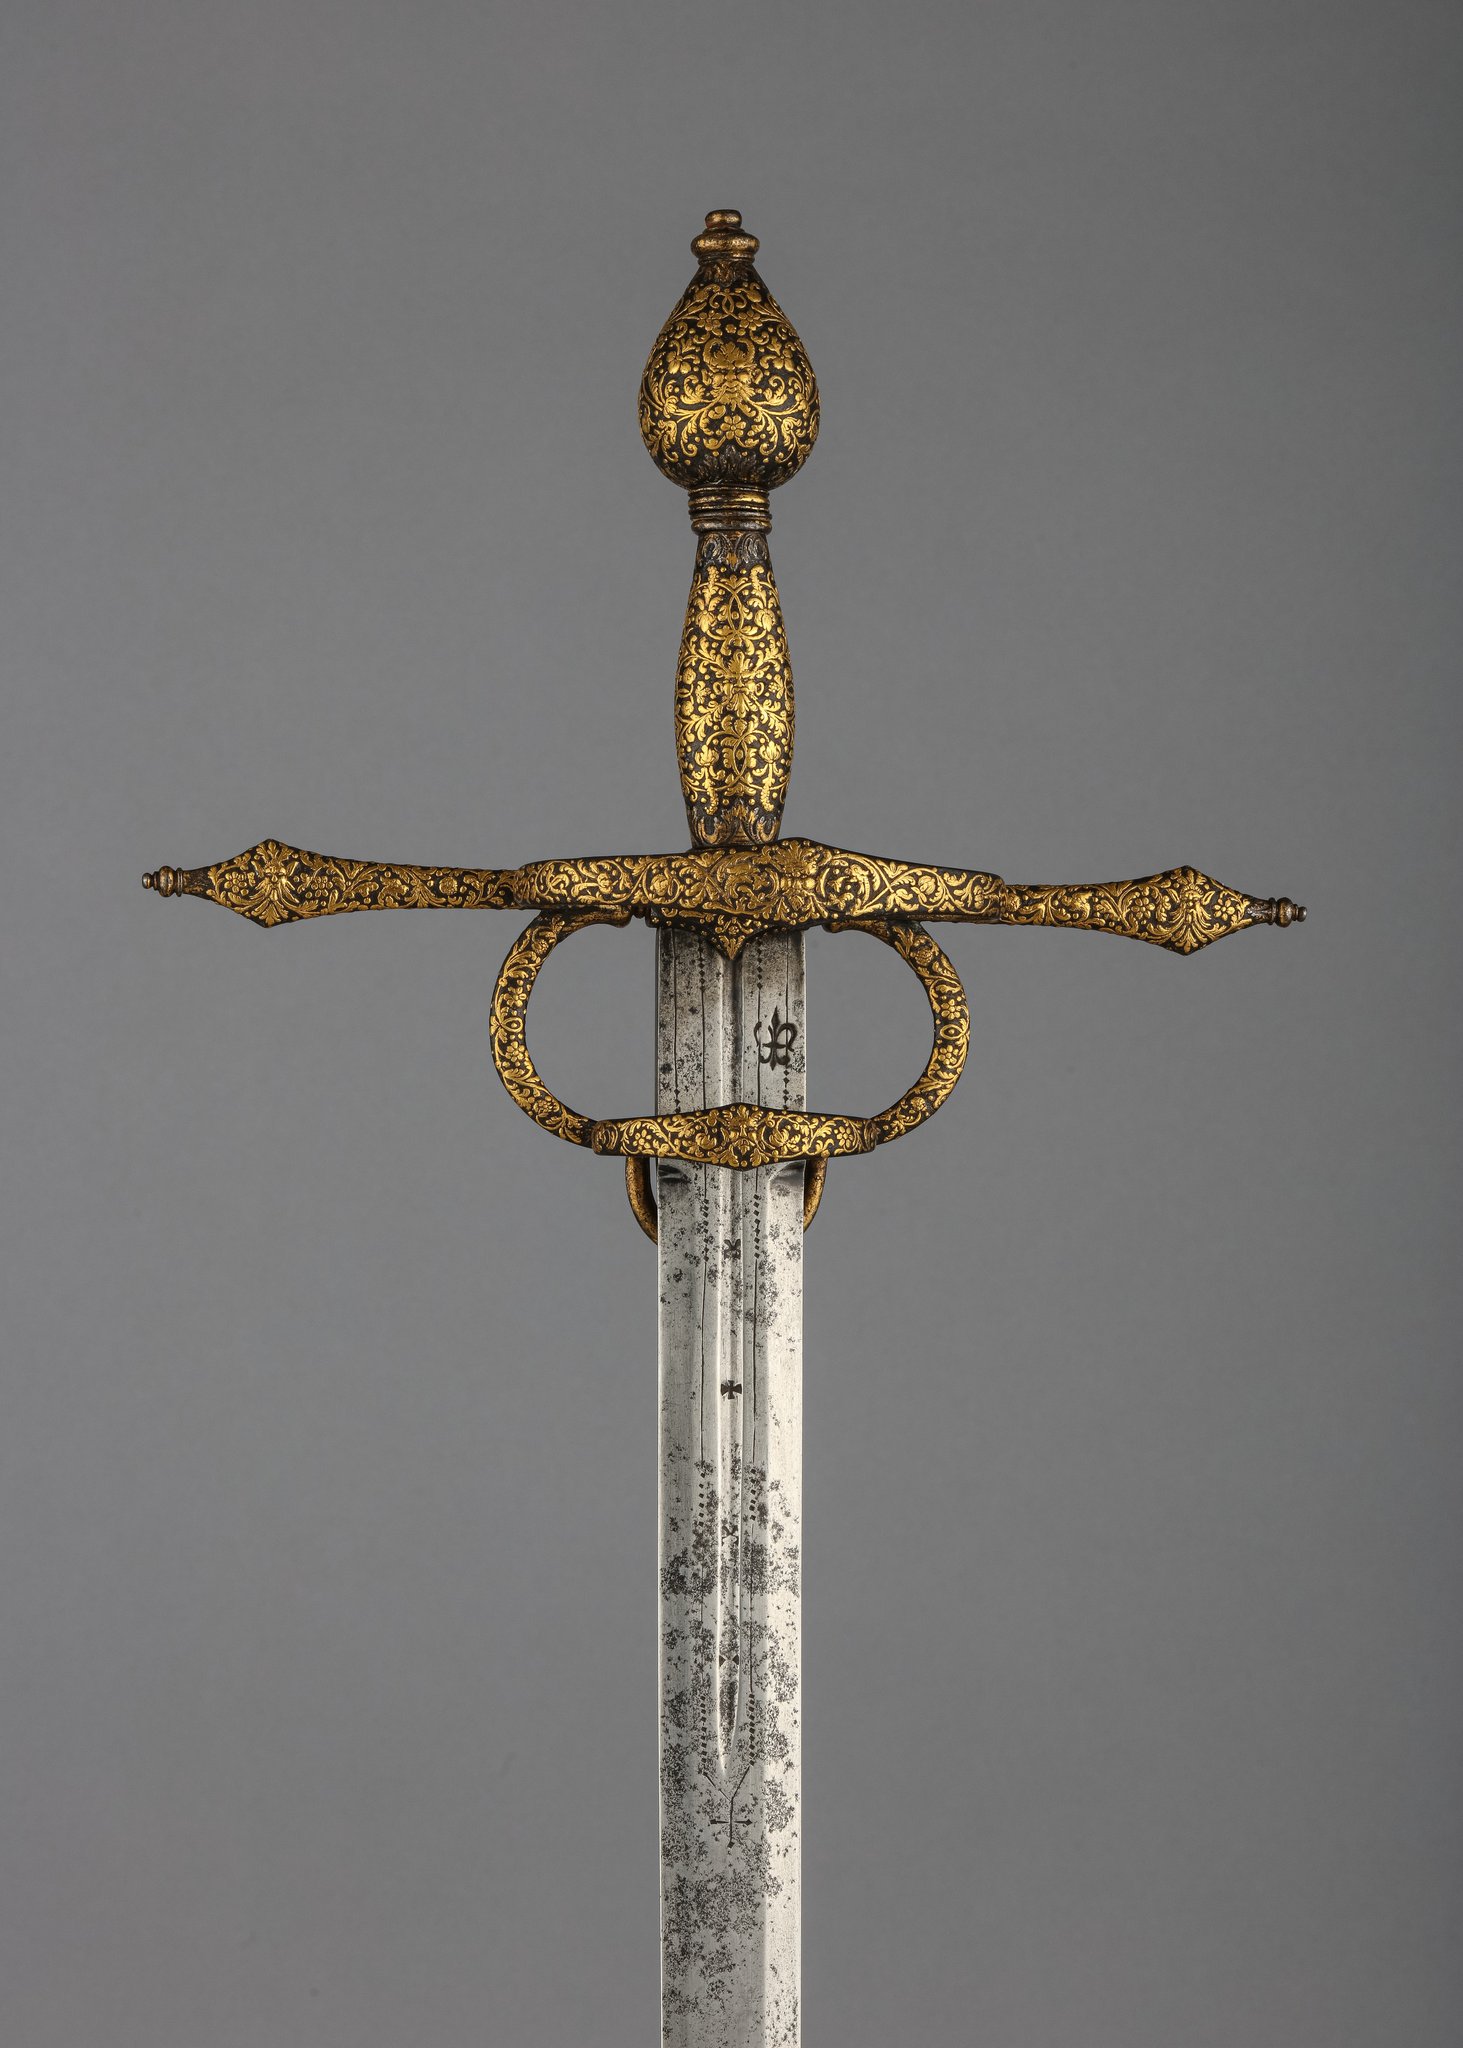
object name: rapier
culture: italian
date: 1560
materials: gold, iron, steel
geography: italy